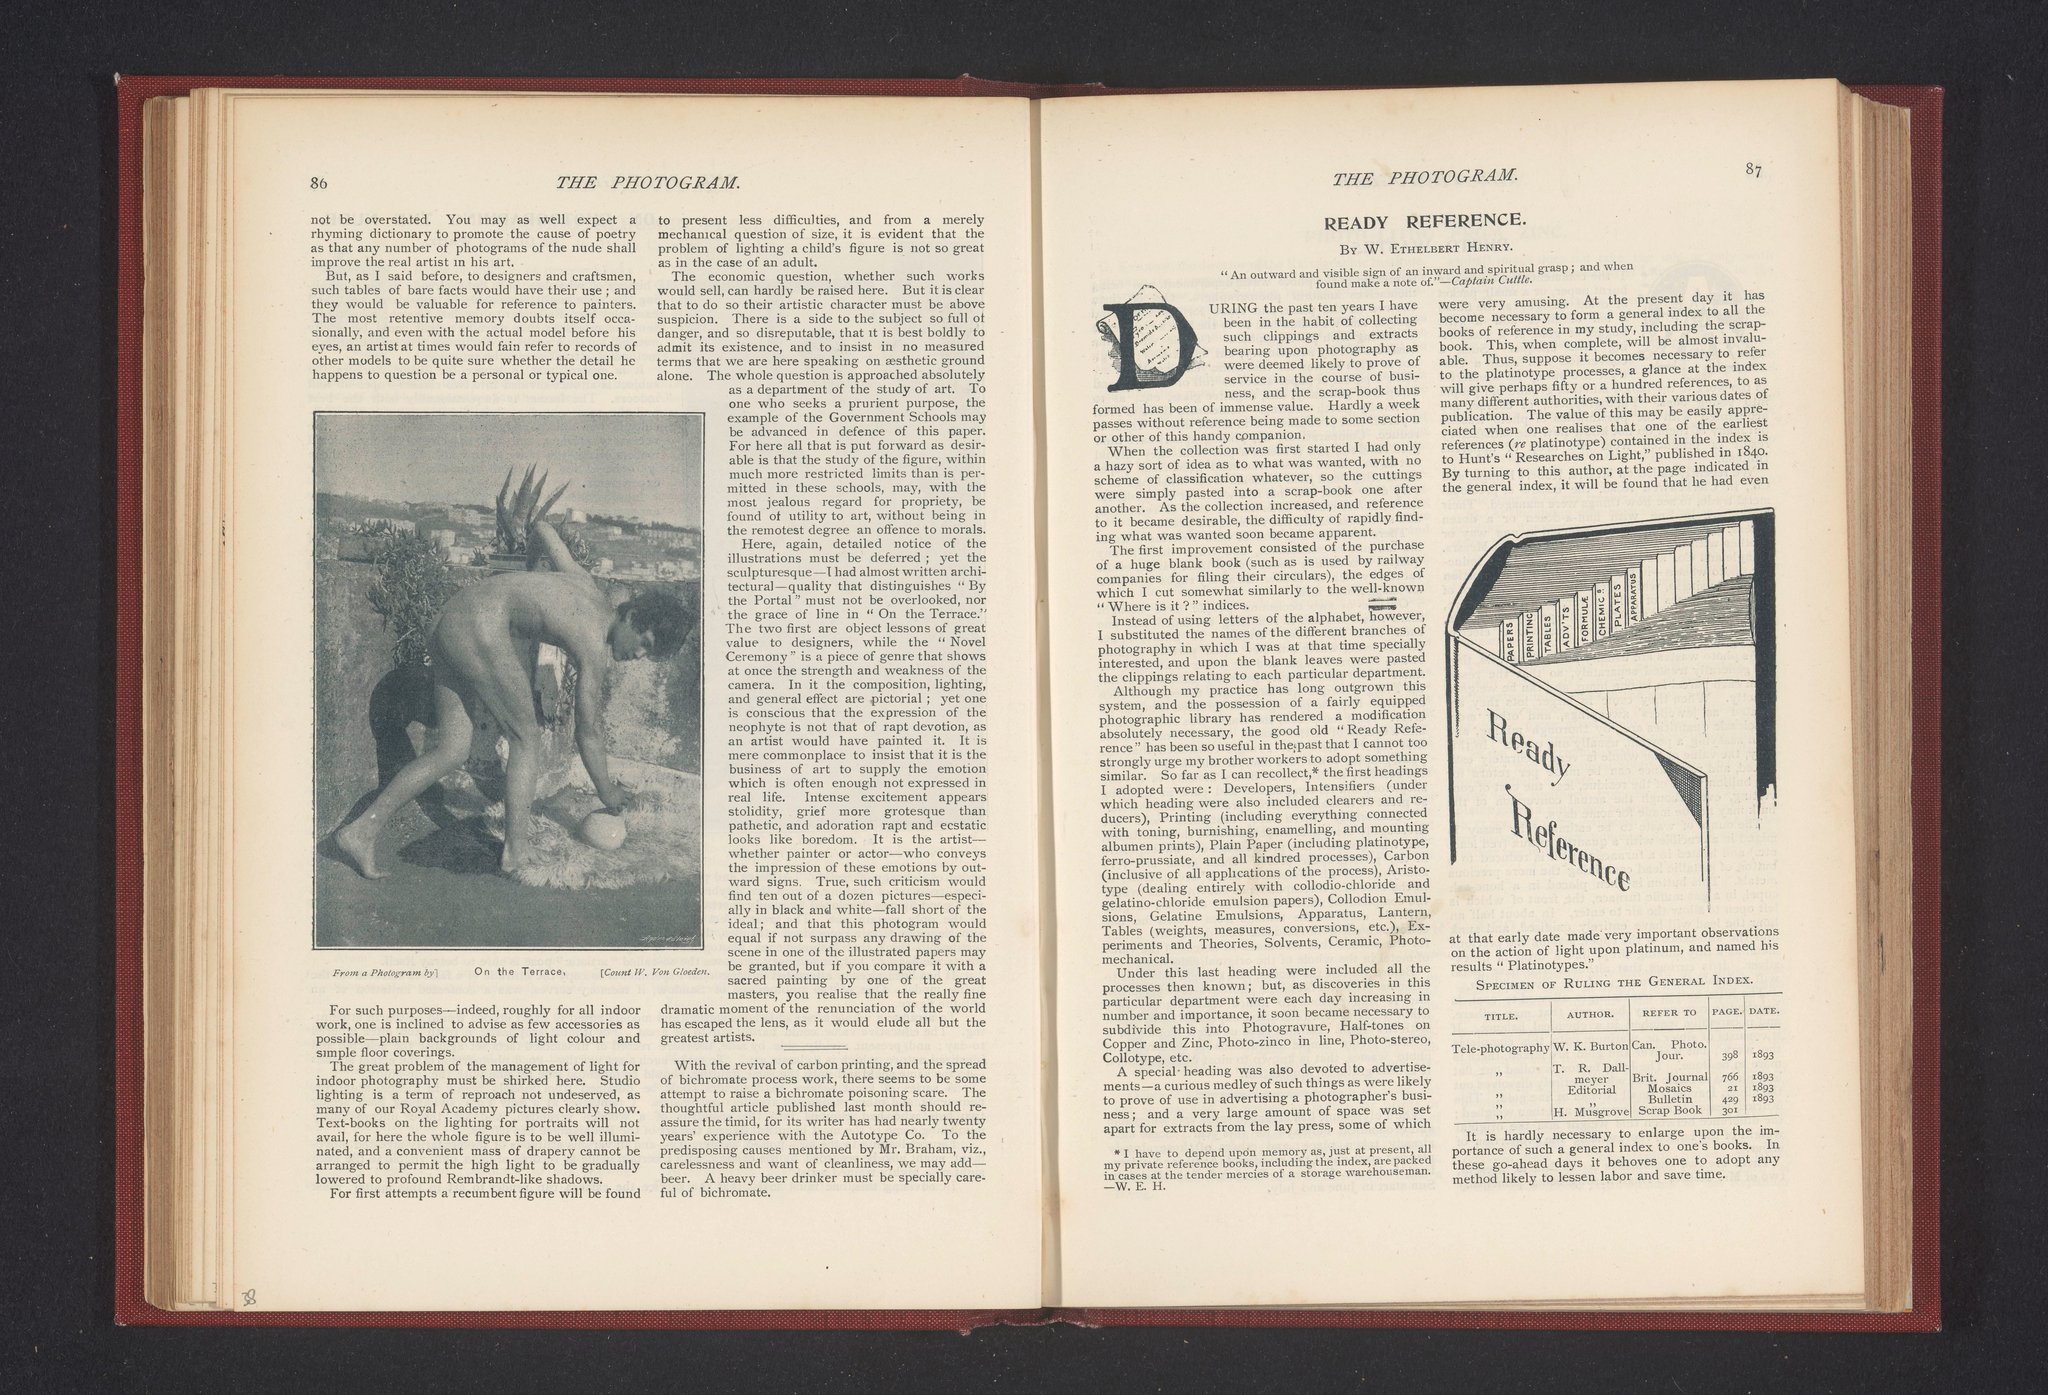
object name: page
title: Naakte jongen op een terras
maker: wilhelm von gloeden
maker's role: fotograaf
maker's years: 1856-1931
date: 1889-1894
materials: paper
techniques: autotype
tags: the (nude) human figure; 'corpo humano' (ripa), terrace